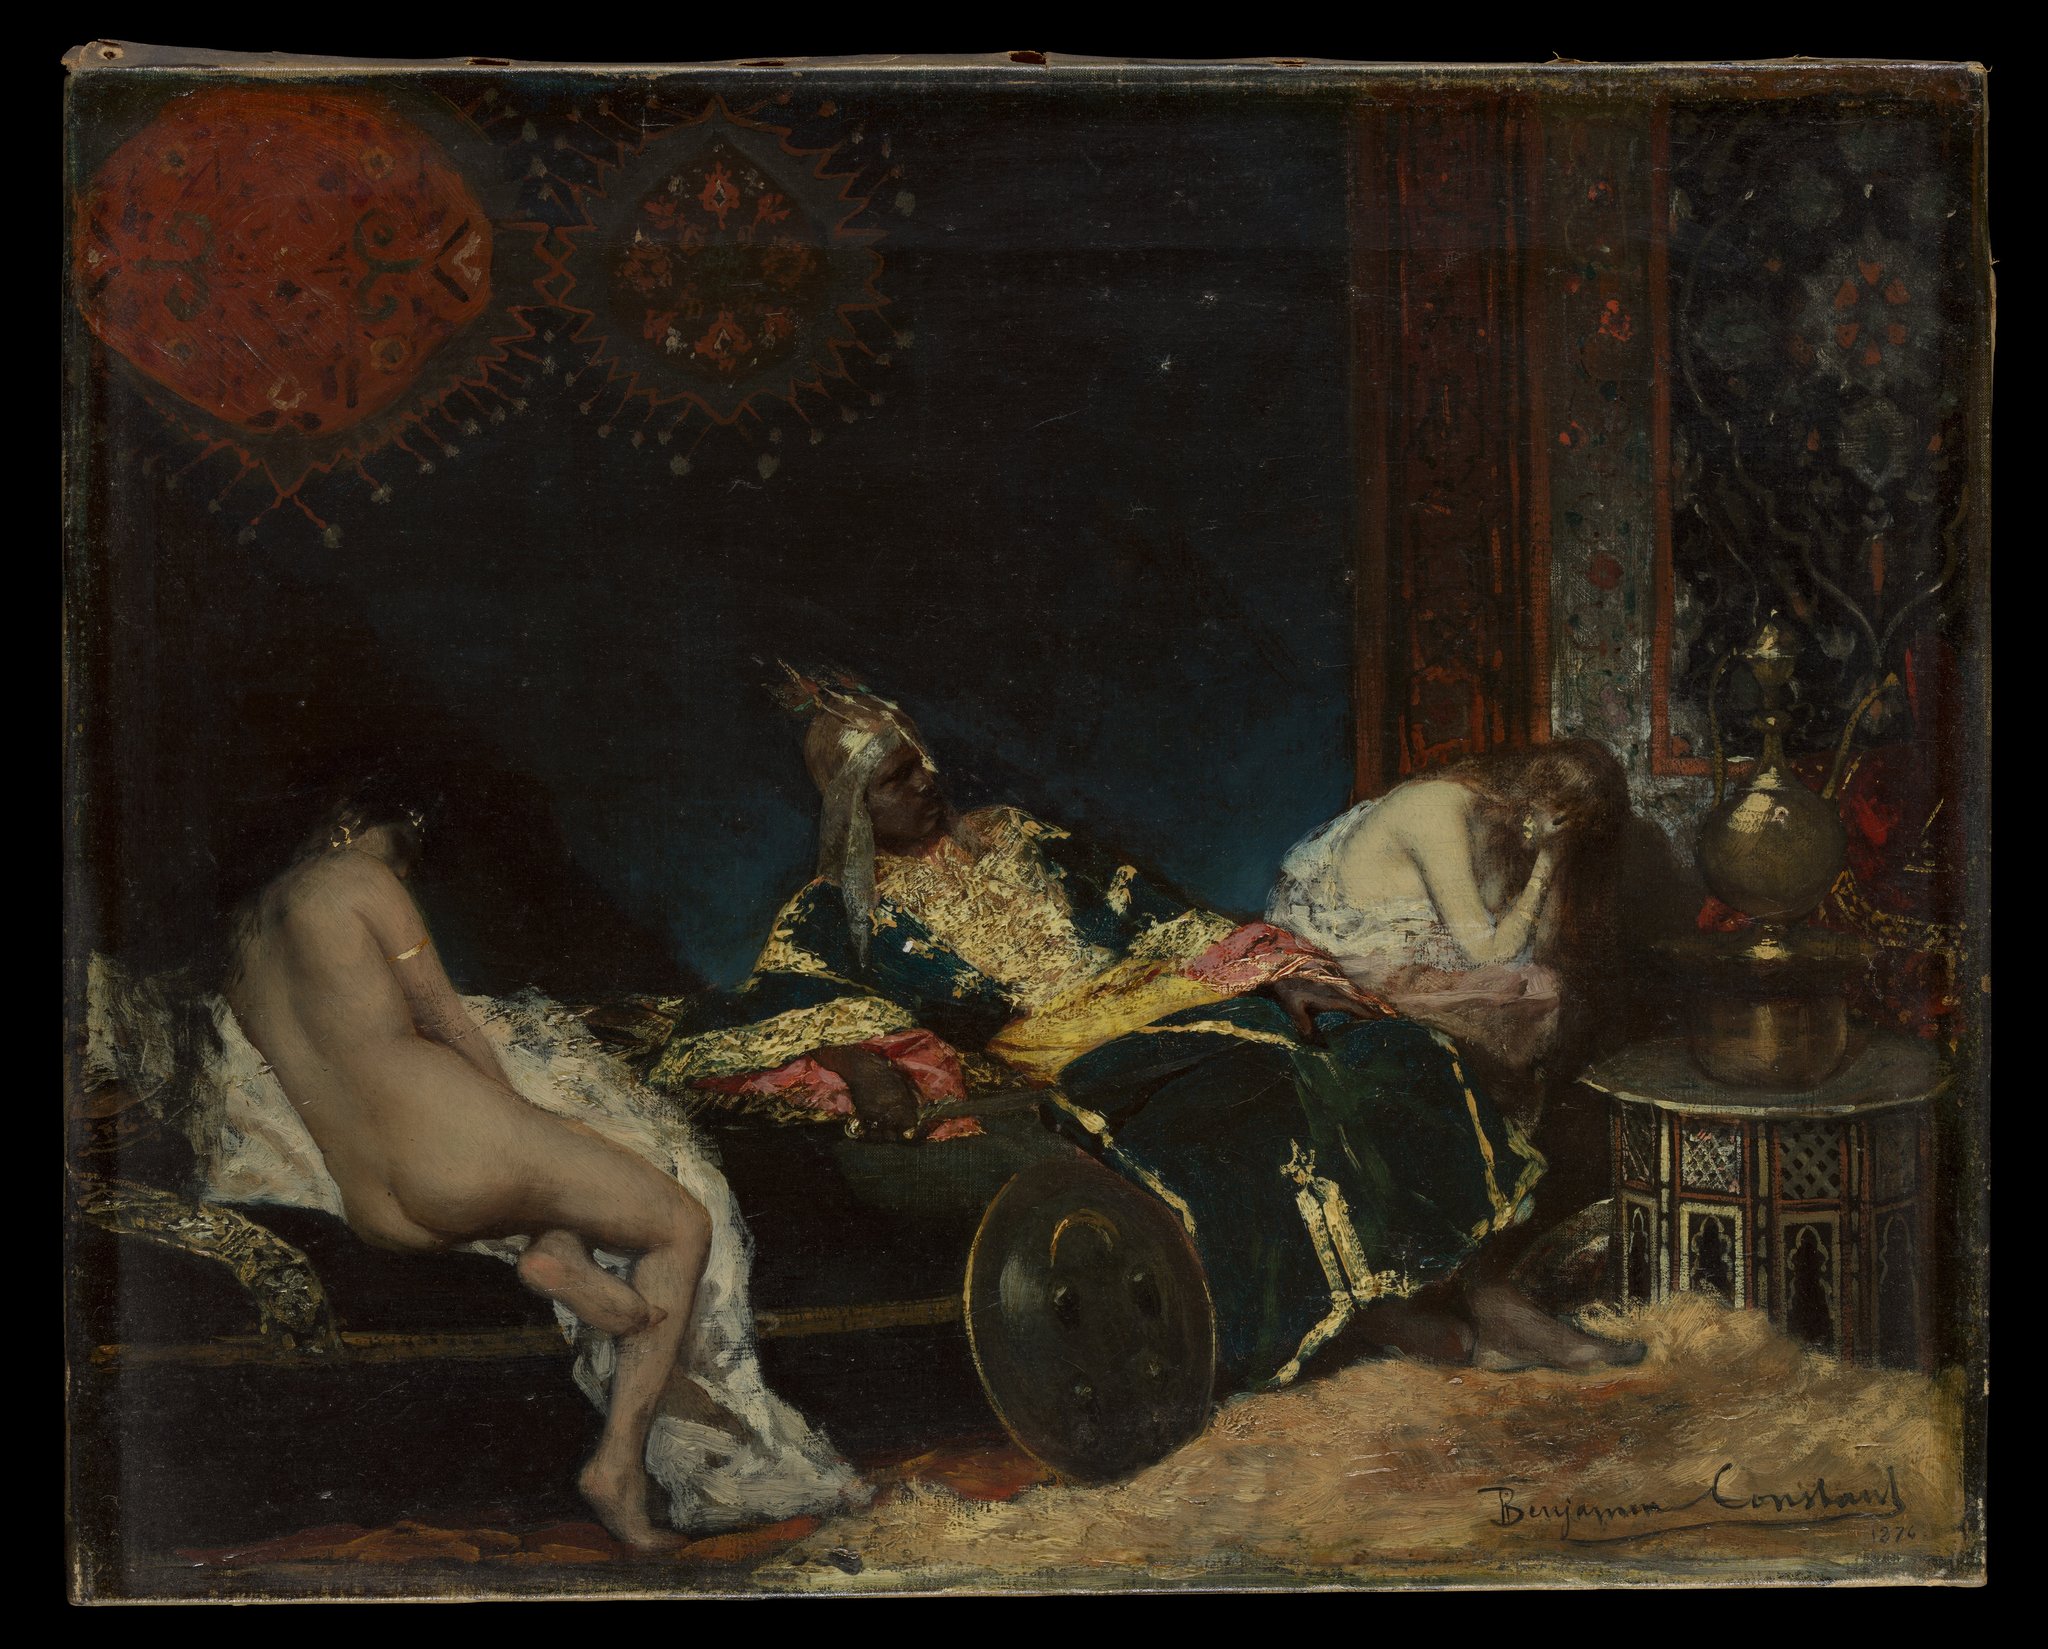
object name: painting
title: Scene in a Harem (Un Envoi de Serbie)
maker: benjamin-constant (jean-joseph-benjamin constant)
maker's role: artist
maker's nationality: french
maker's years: 1845-1902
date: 1876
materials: canvas, oil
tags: men,women,female nudes,orientalist